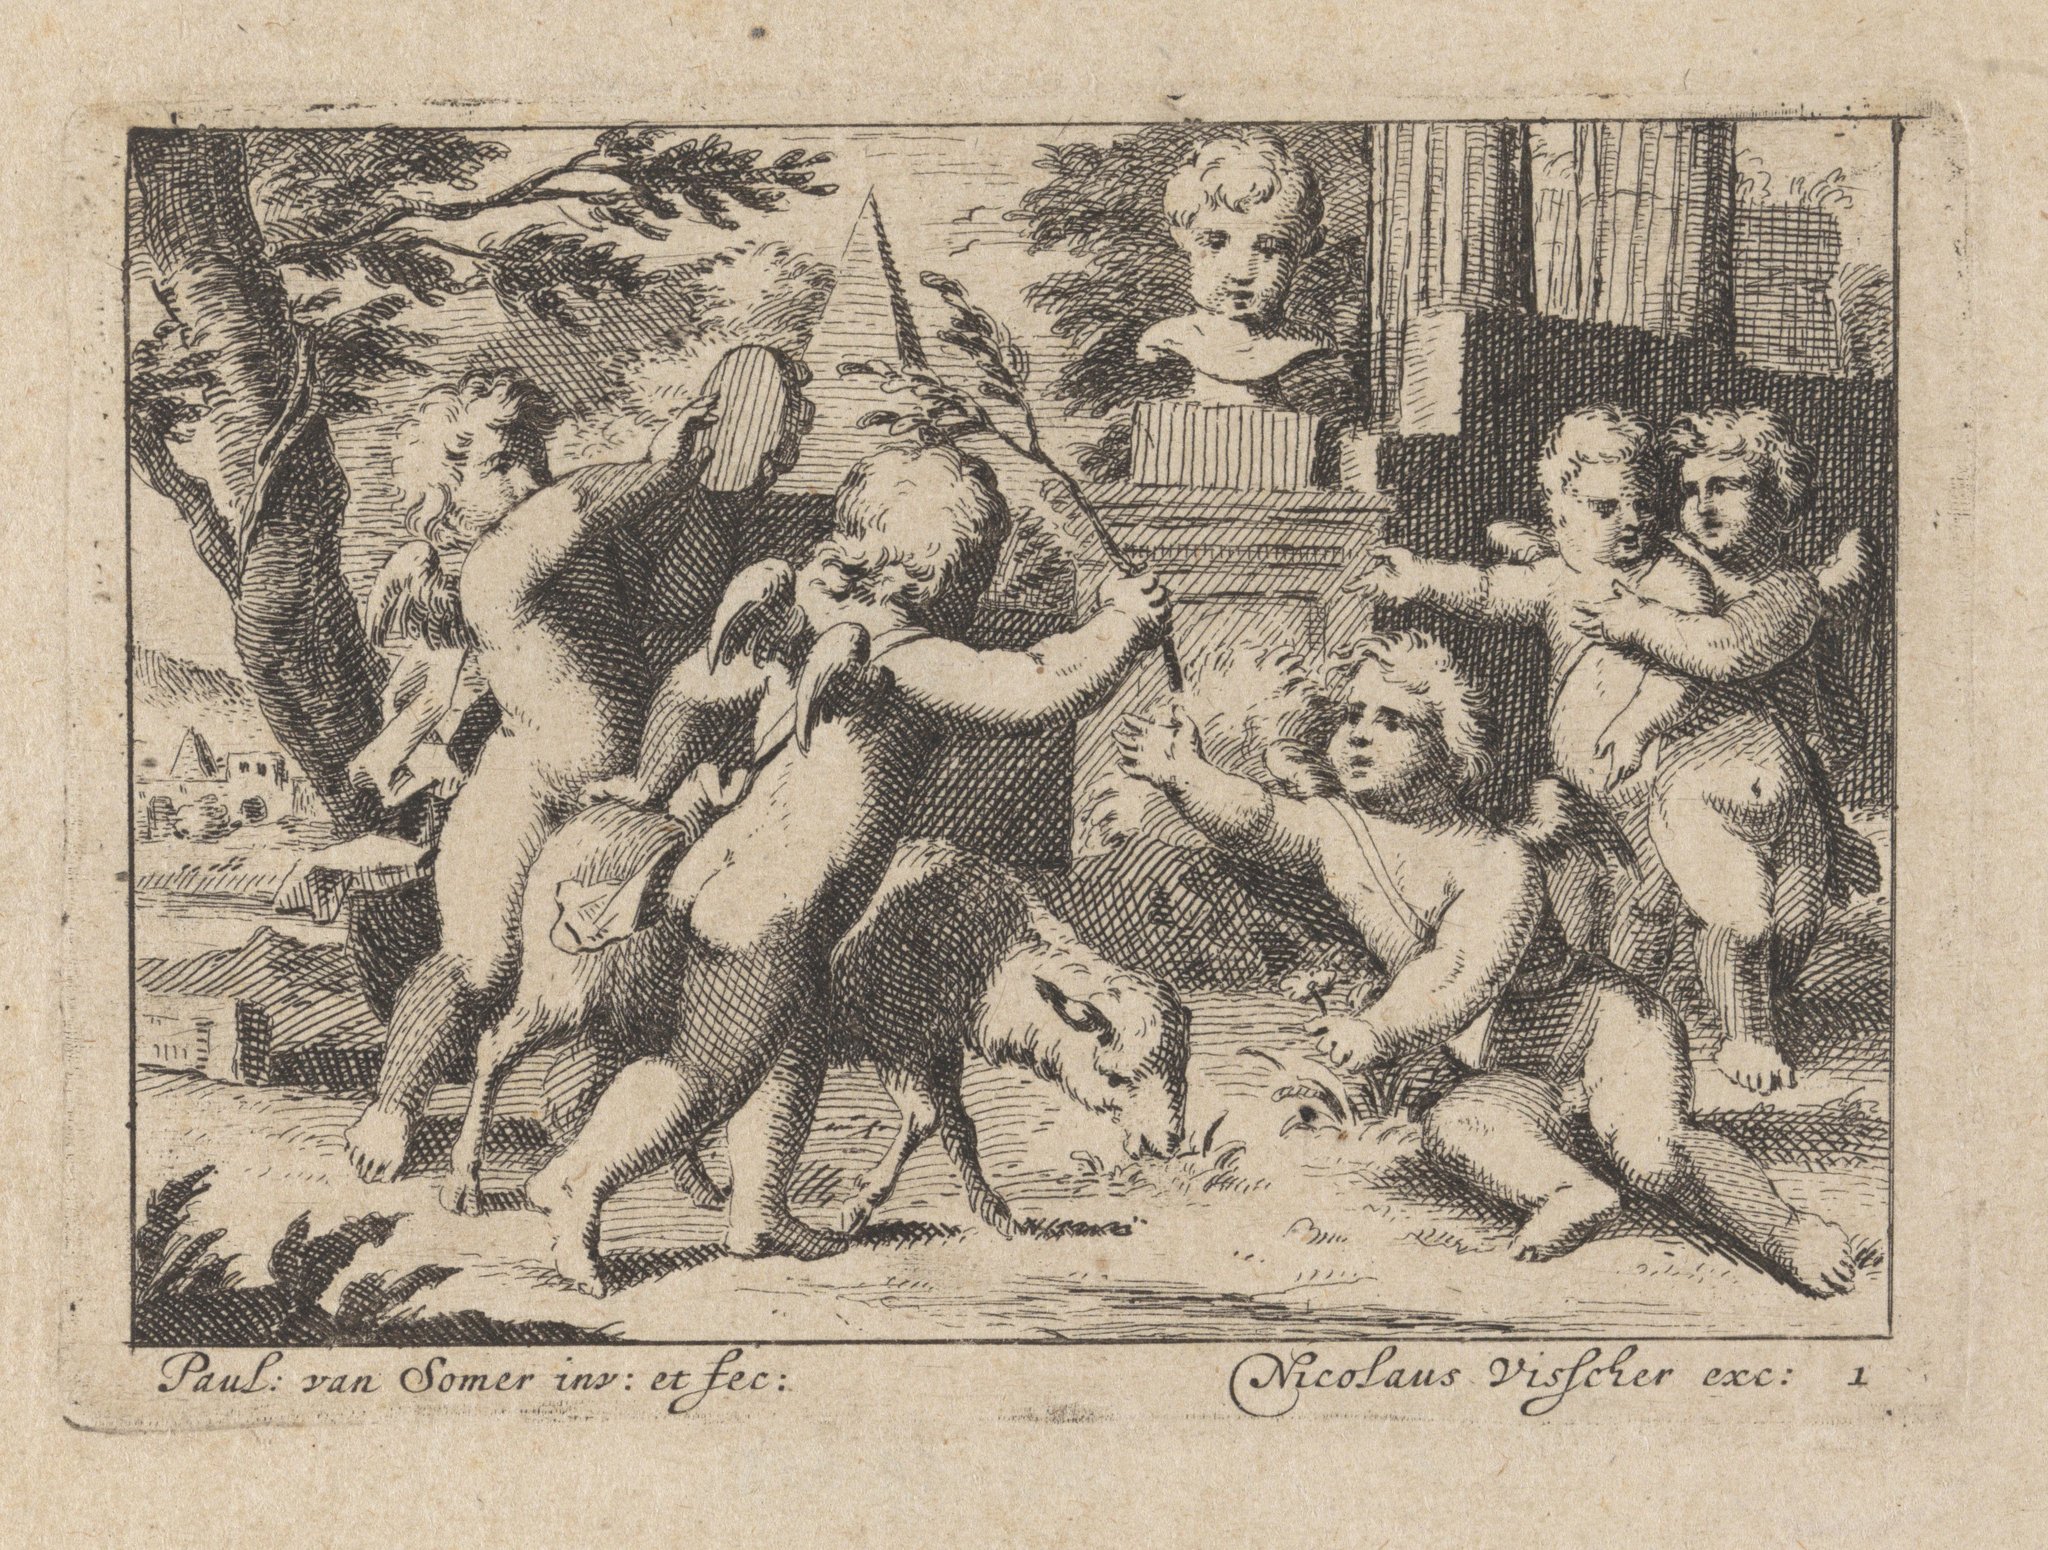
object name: print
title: Putti met een lam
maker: paul van somer (ii)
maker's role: draughtsman, print maker, publisher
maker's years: 1639-1704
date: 1670-1697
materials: paper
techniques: etching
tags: cupids: 'amores', 'amoretti', 'putti'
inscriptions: collector's mark: Lugt 240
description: In een landschap met ruïne spelen putti met een lam. Op een muurtje staat een borstbeeld van een kind.